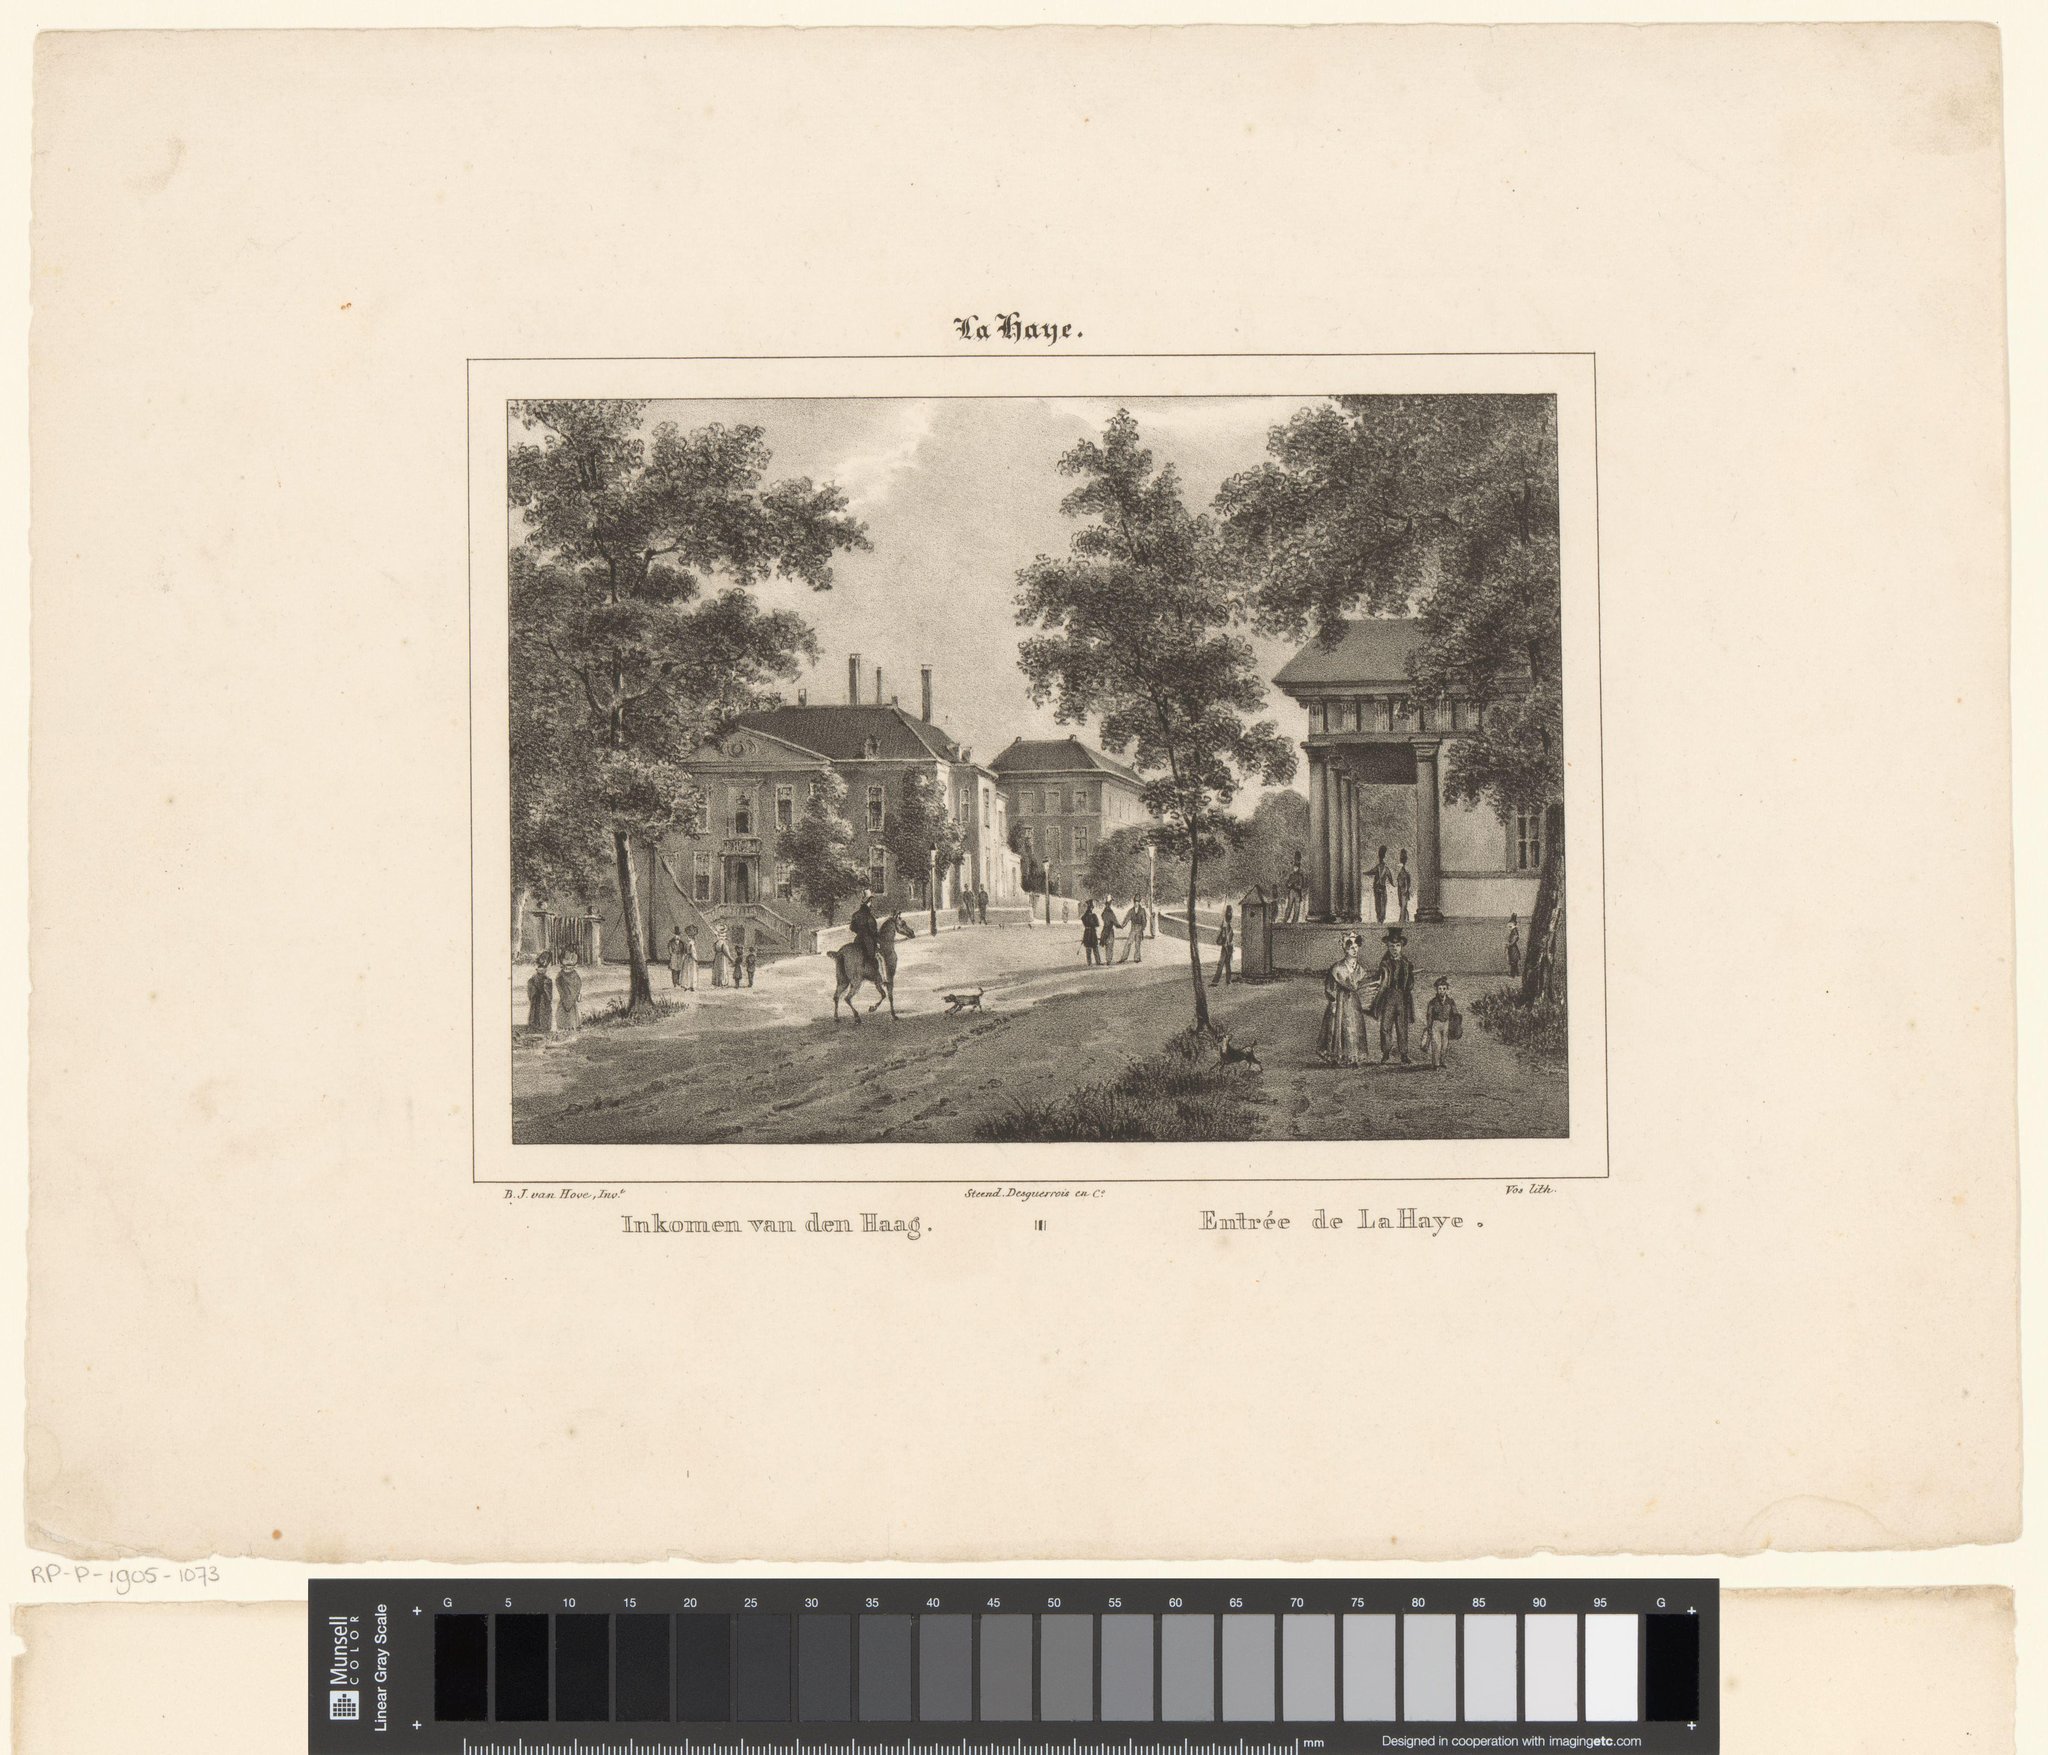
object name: print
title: Inkomen van den Haag / Entrée de La Haye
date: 1827-1853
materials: paper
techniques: lithograph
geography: amsterdam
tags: city-view in general; 'veduta', the hague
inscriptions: collector's mark: Lugt 2228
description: Gezicht op het Korte Voorhout, bij de Koningsbrug, of Boschburg, met rechts 'Het Wachtje', het wachthuis. Op straat lopen mensen en een ruiter te paard.